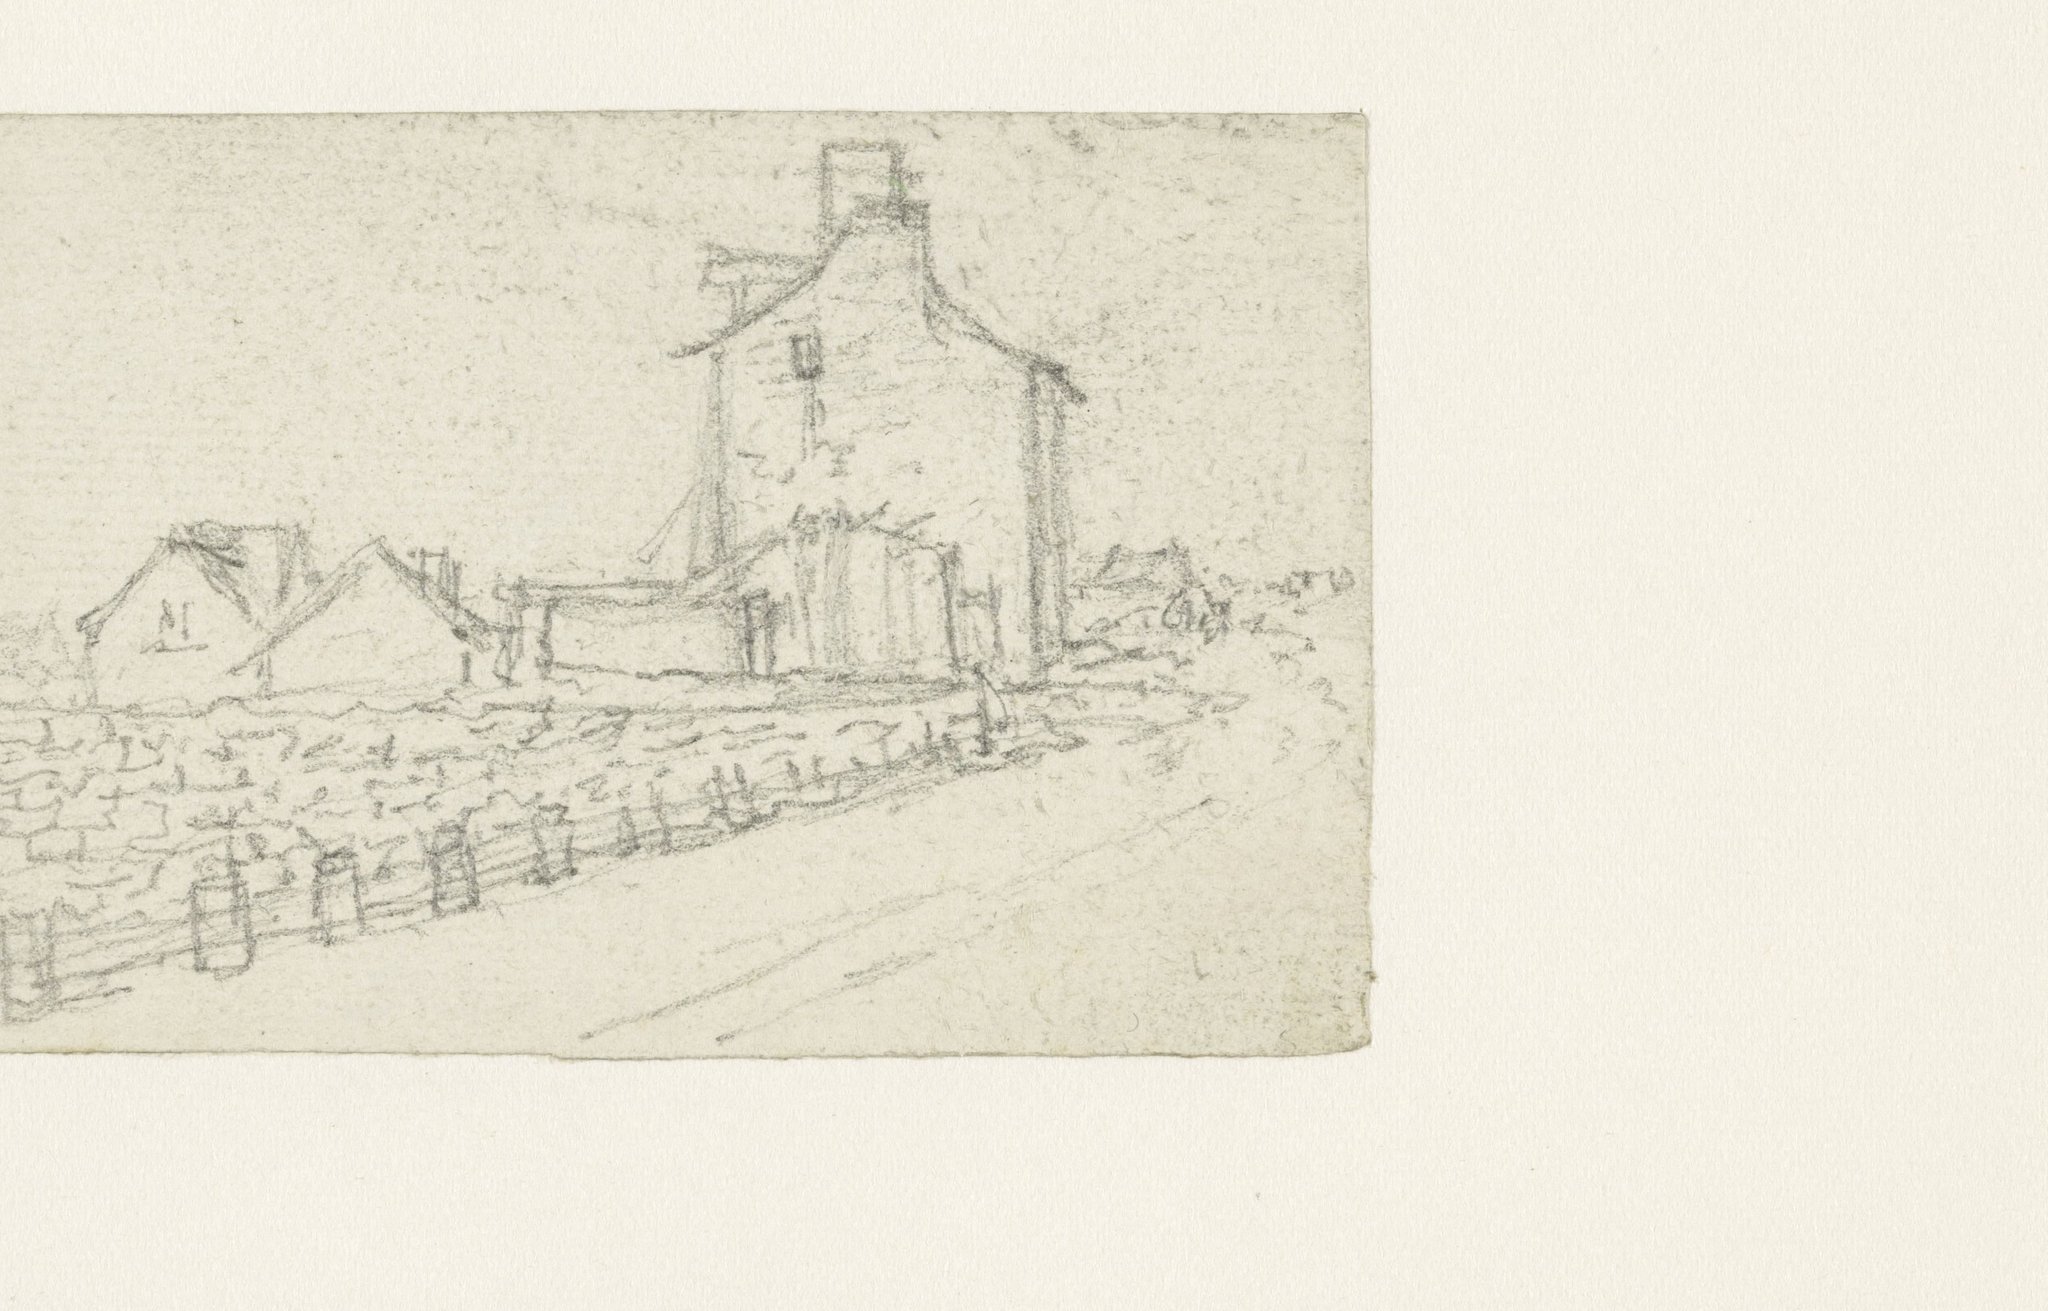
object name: drawing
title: Weg met muur erlangs leidend naar een huis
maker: georges michel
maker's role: draughtsman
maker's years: 1763-1843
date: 1773-1843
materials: paper, pencil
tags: public road in village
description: Een van 120 tekeningen, afkomstig uit een 19e eeuws album met tekeningen van Georges Michel.